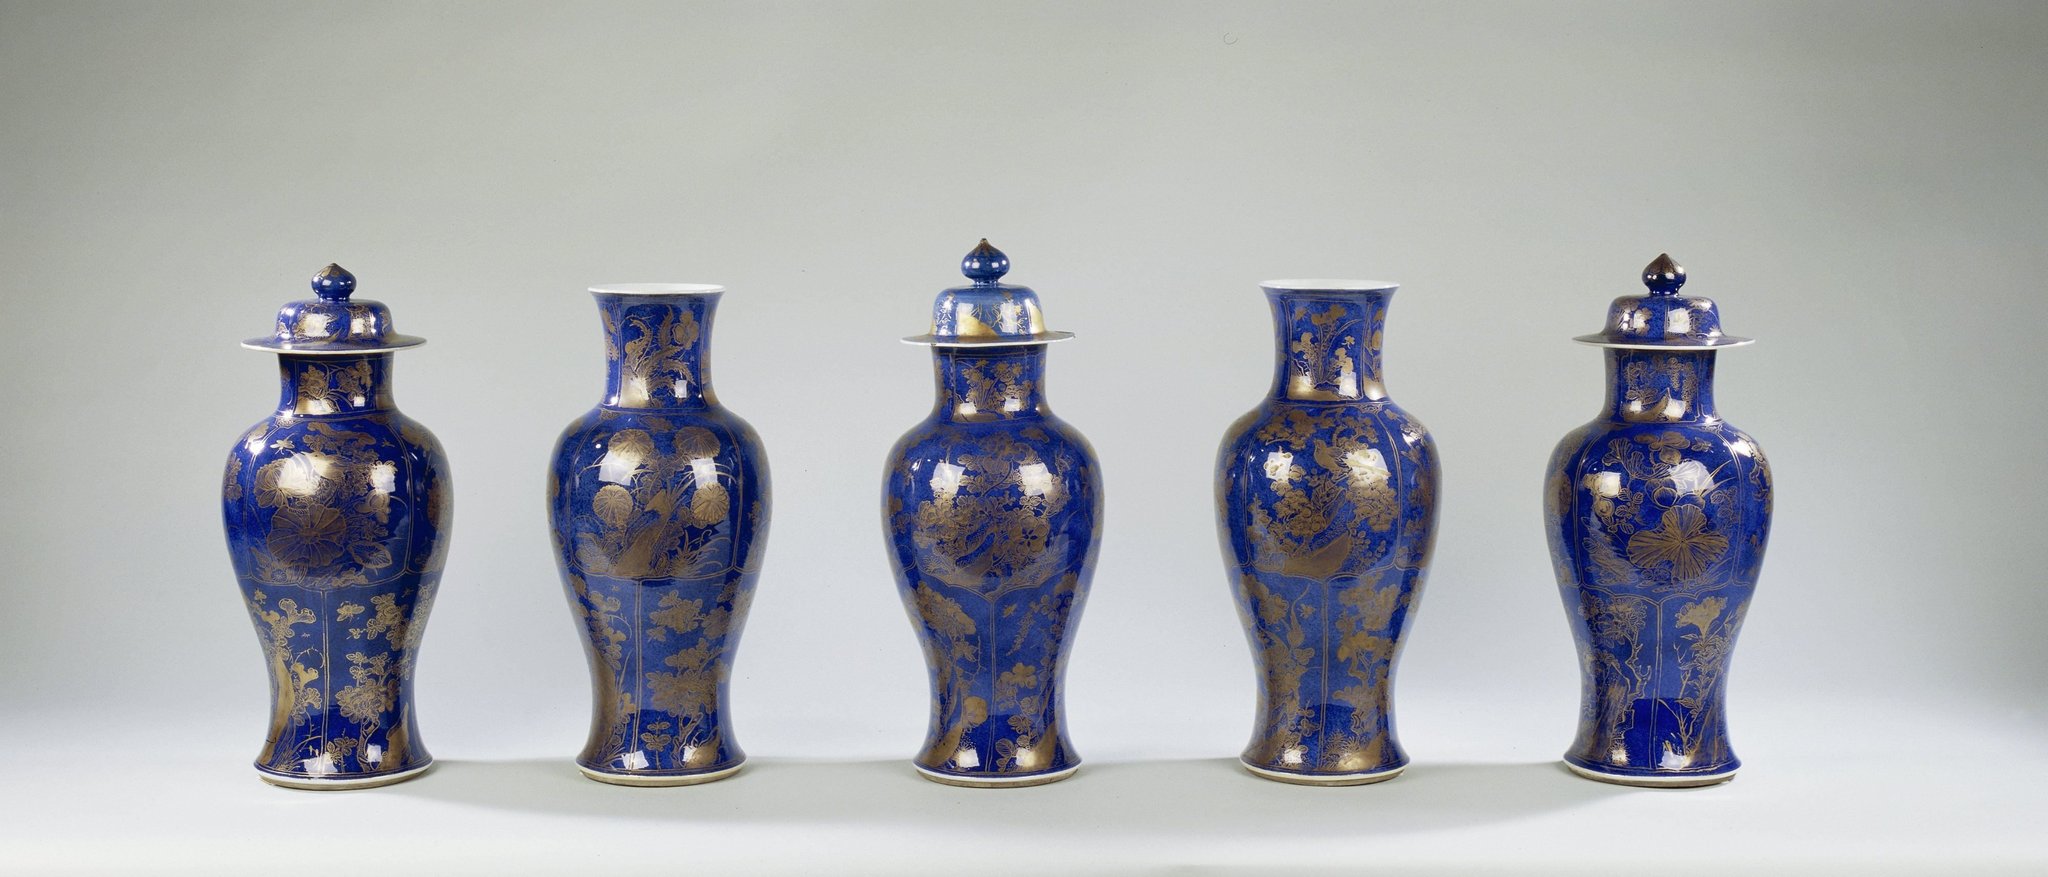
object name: kaststel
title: Five-pieve garniture with with powder blue and flowering plants and animals in panel decoration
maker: Anonymous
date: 1700-1724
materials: cobalt, glaze, paint, porcelain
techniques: firing, gilding, turning, vitrification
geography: china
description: Vijfdelig kaststel van porselein, bestaande uit twee bekervazen en drie dekselvazen. Beschilderd in onderglazuur blauw en op het glazuur goud met drie rijen met vakken: de onderste rij heeft in elk vak een andere bloeiende plant of boom bij een rots met insecten; de tweede rij is ook met vier verschillende bloeiende planten (lotus, chrysant, prunus, pioen) met vogels en/of vlinders. Bleu poudré met goud.